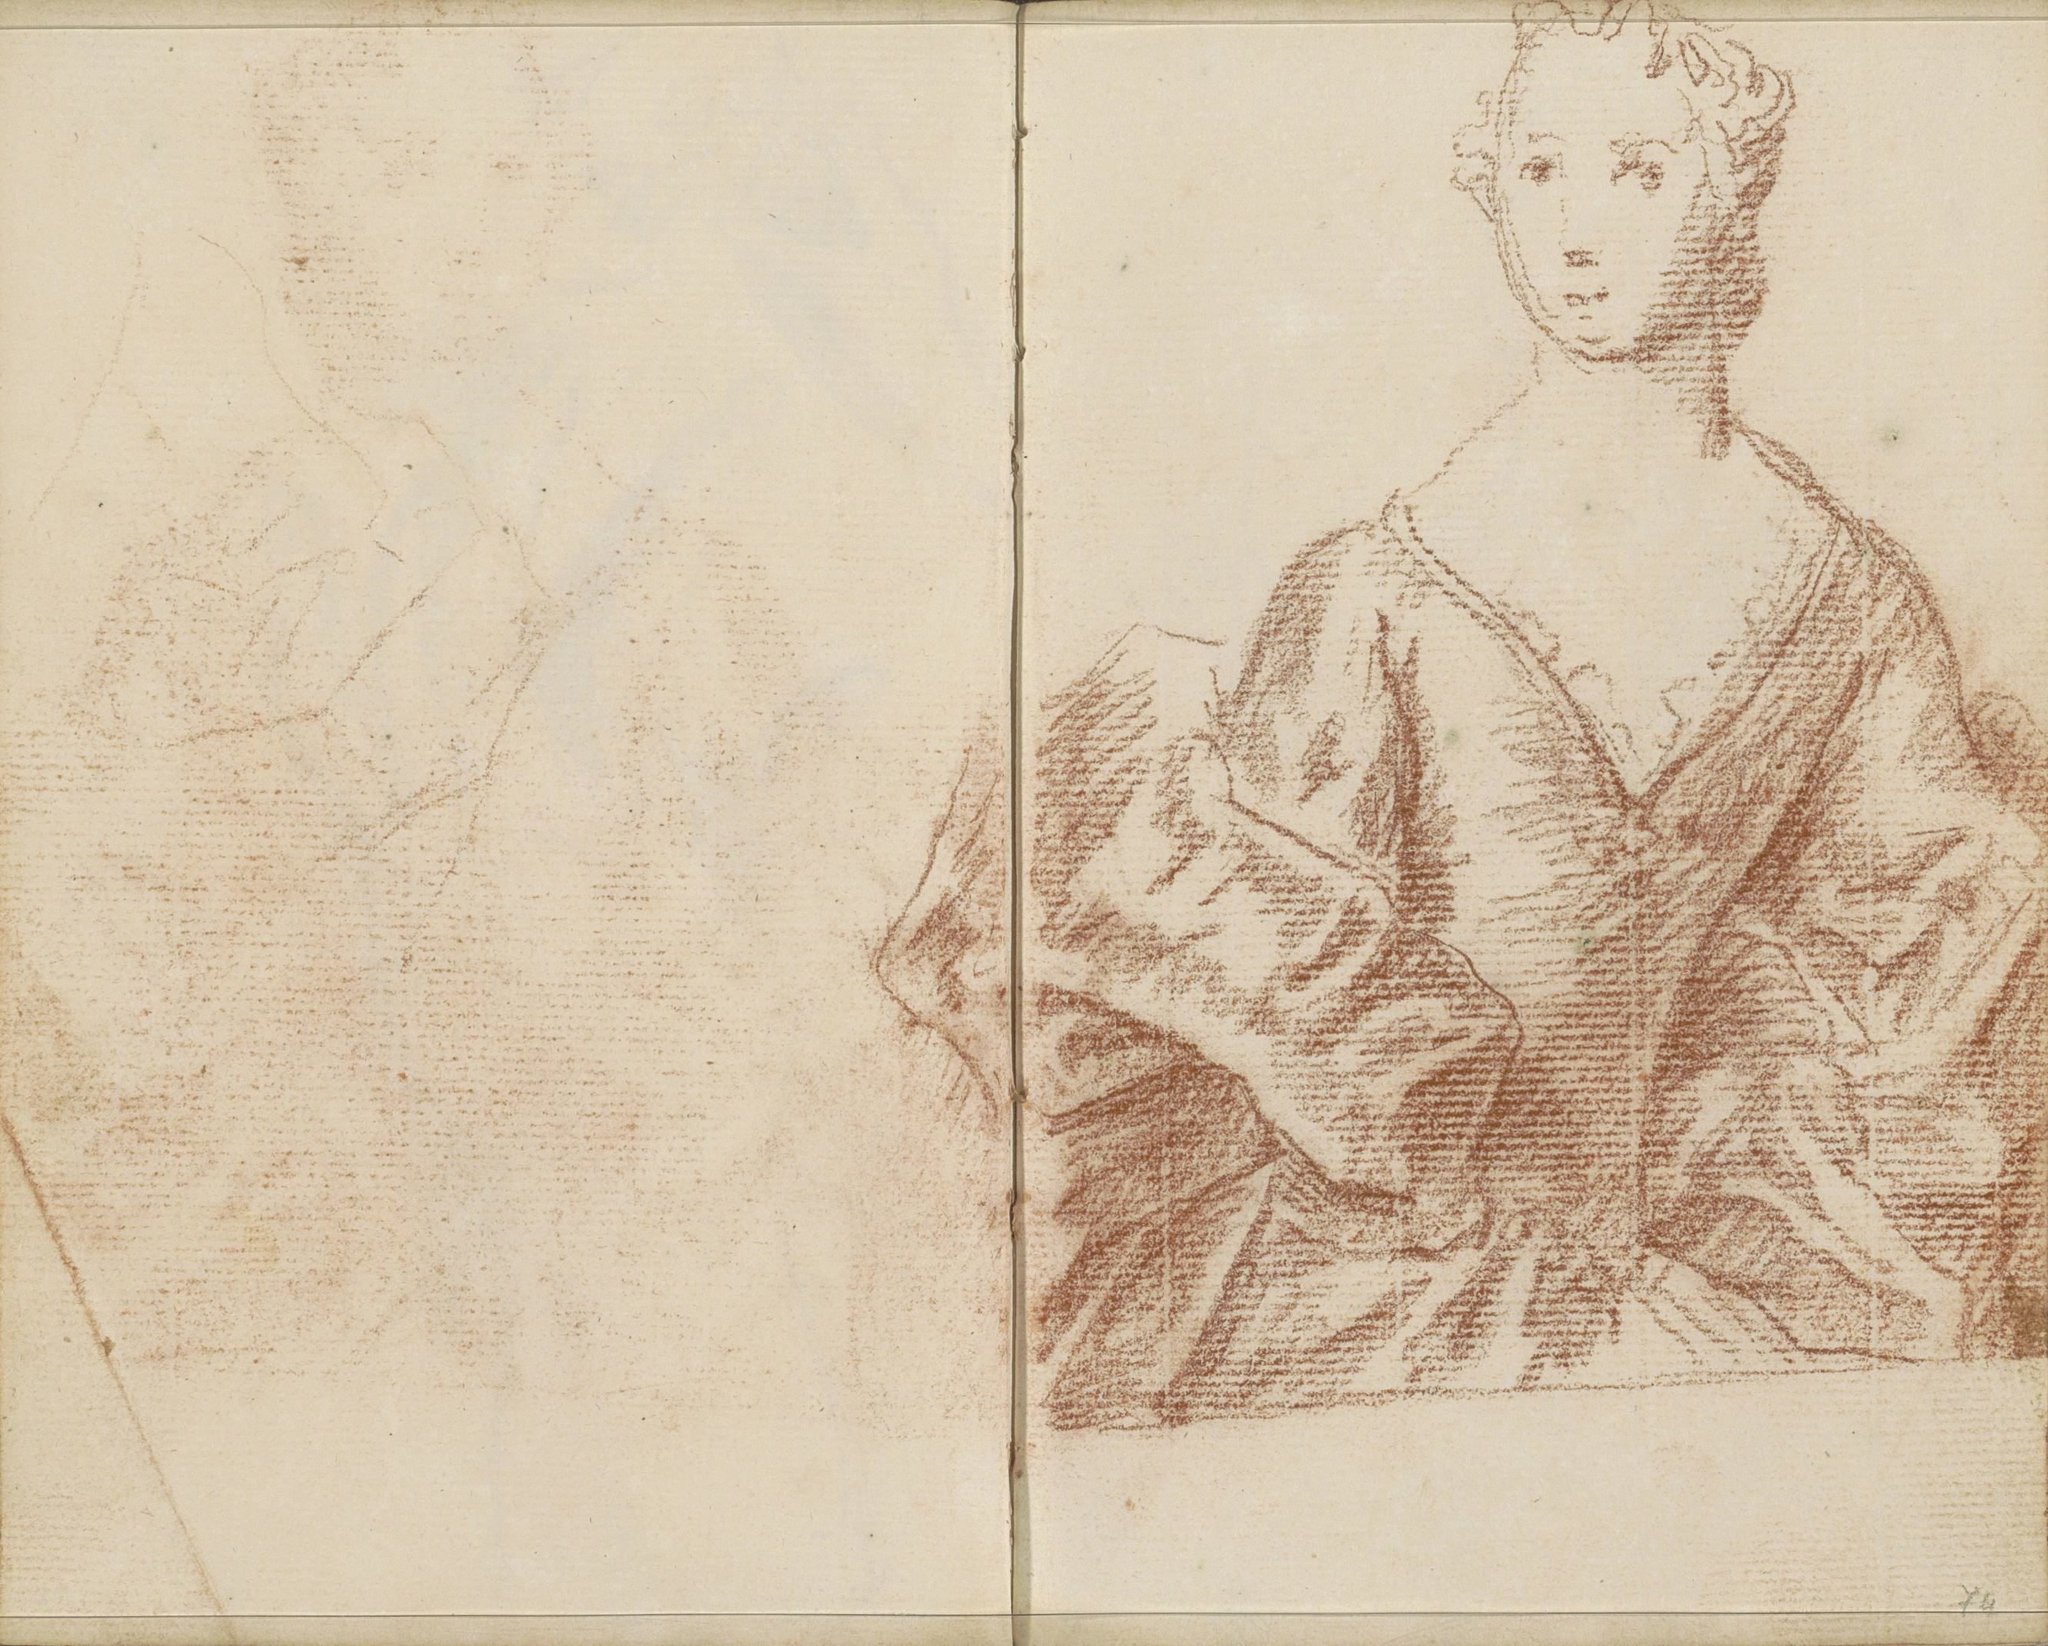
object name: sketchbook leaf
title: Vrouw in een japon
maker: petrus johannes van reysschoot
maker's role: draughtsman, print maker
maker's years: 1702-1772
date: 1710-1772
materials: chalk, paper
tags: adult woman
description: Blad 73 verso en 74 recto uit een schetsboek met 105 bladen.